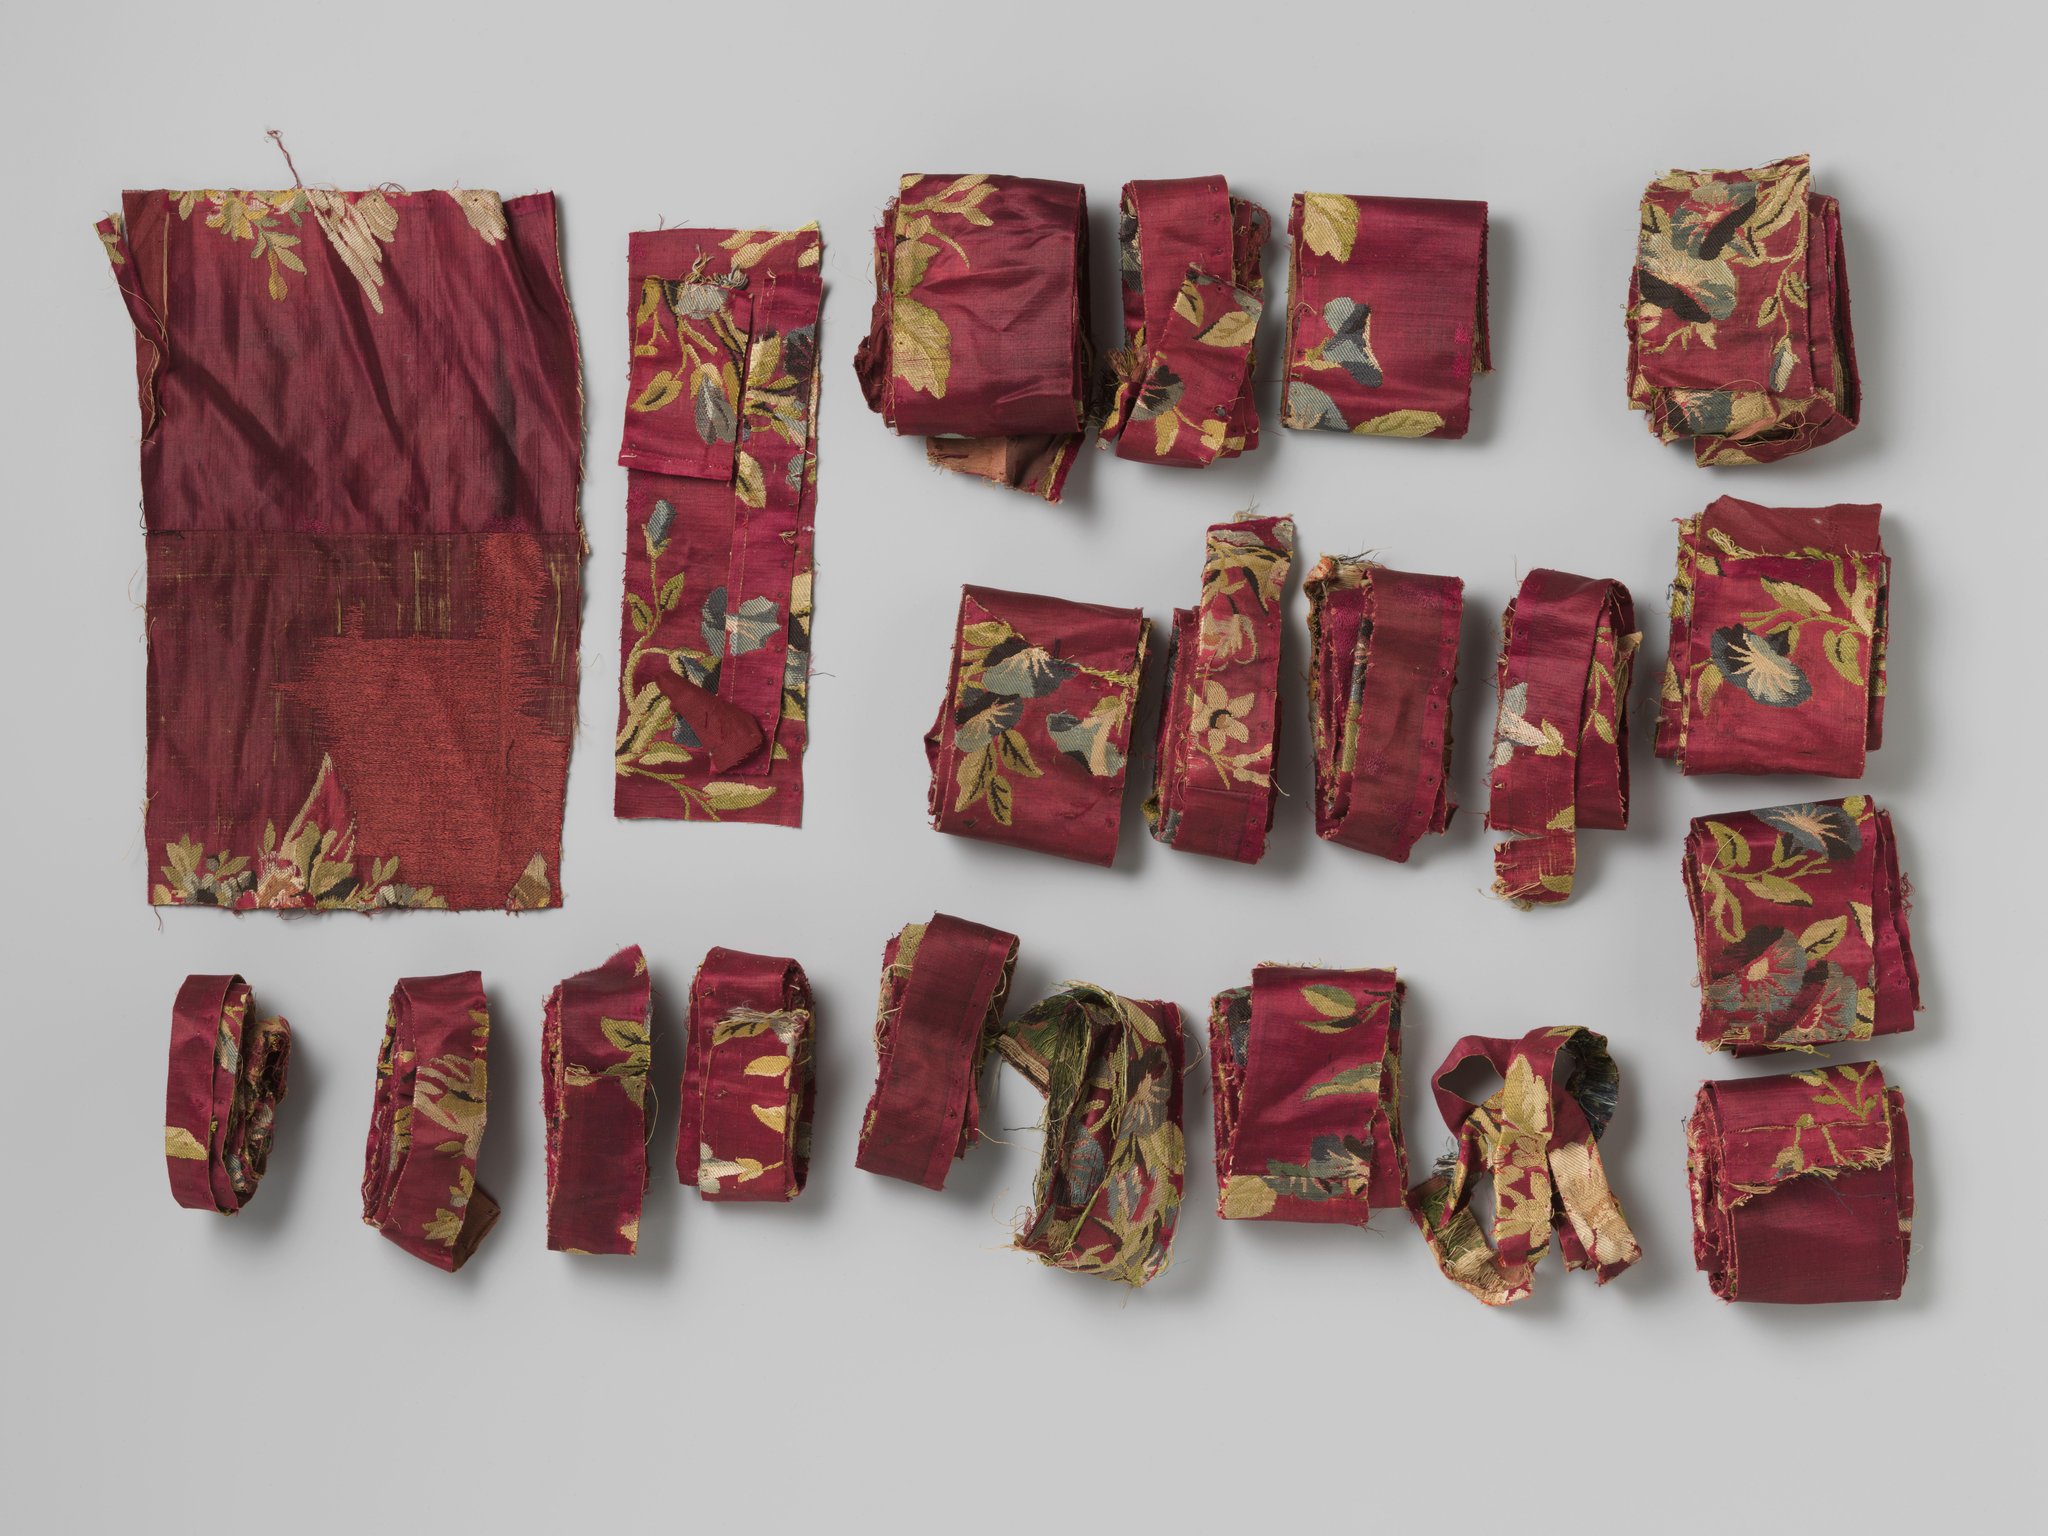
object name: upholstered wall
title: Wandbespanning van lampas met tortelduivenpatroon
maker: philippe de lasalle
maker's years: 1723-1805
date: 1770-1790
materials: silk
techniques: lampas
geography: lyon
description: Smalle fragmenten van een wandbespanning, cersiserood fond met daarop een floraal patroon.